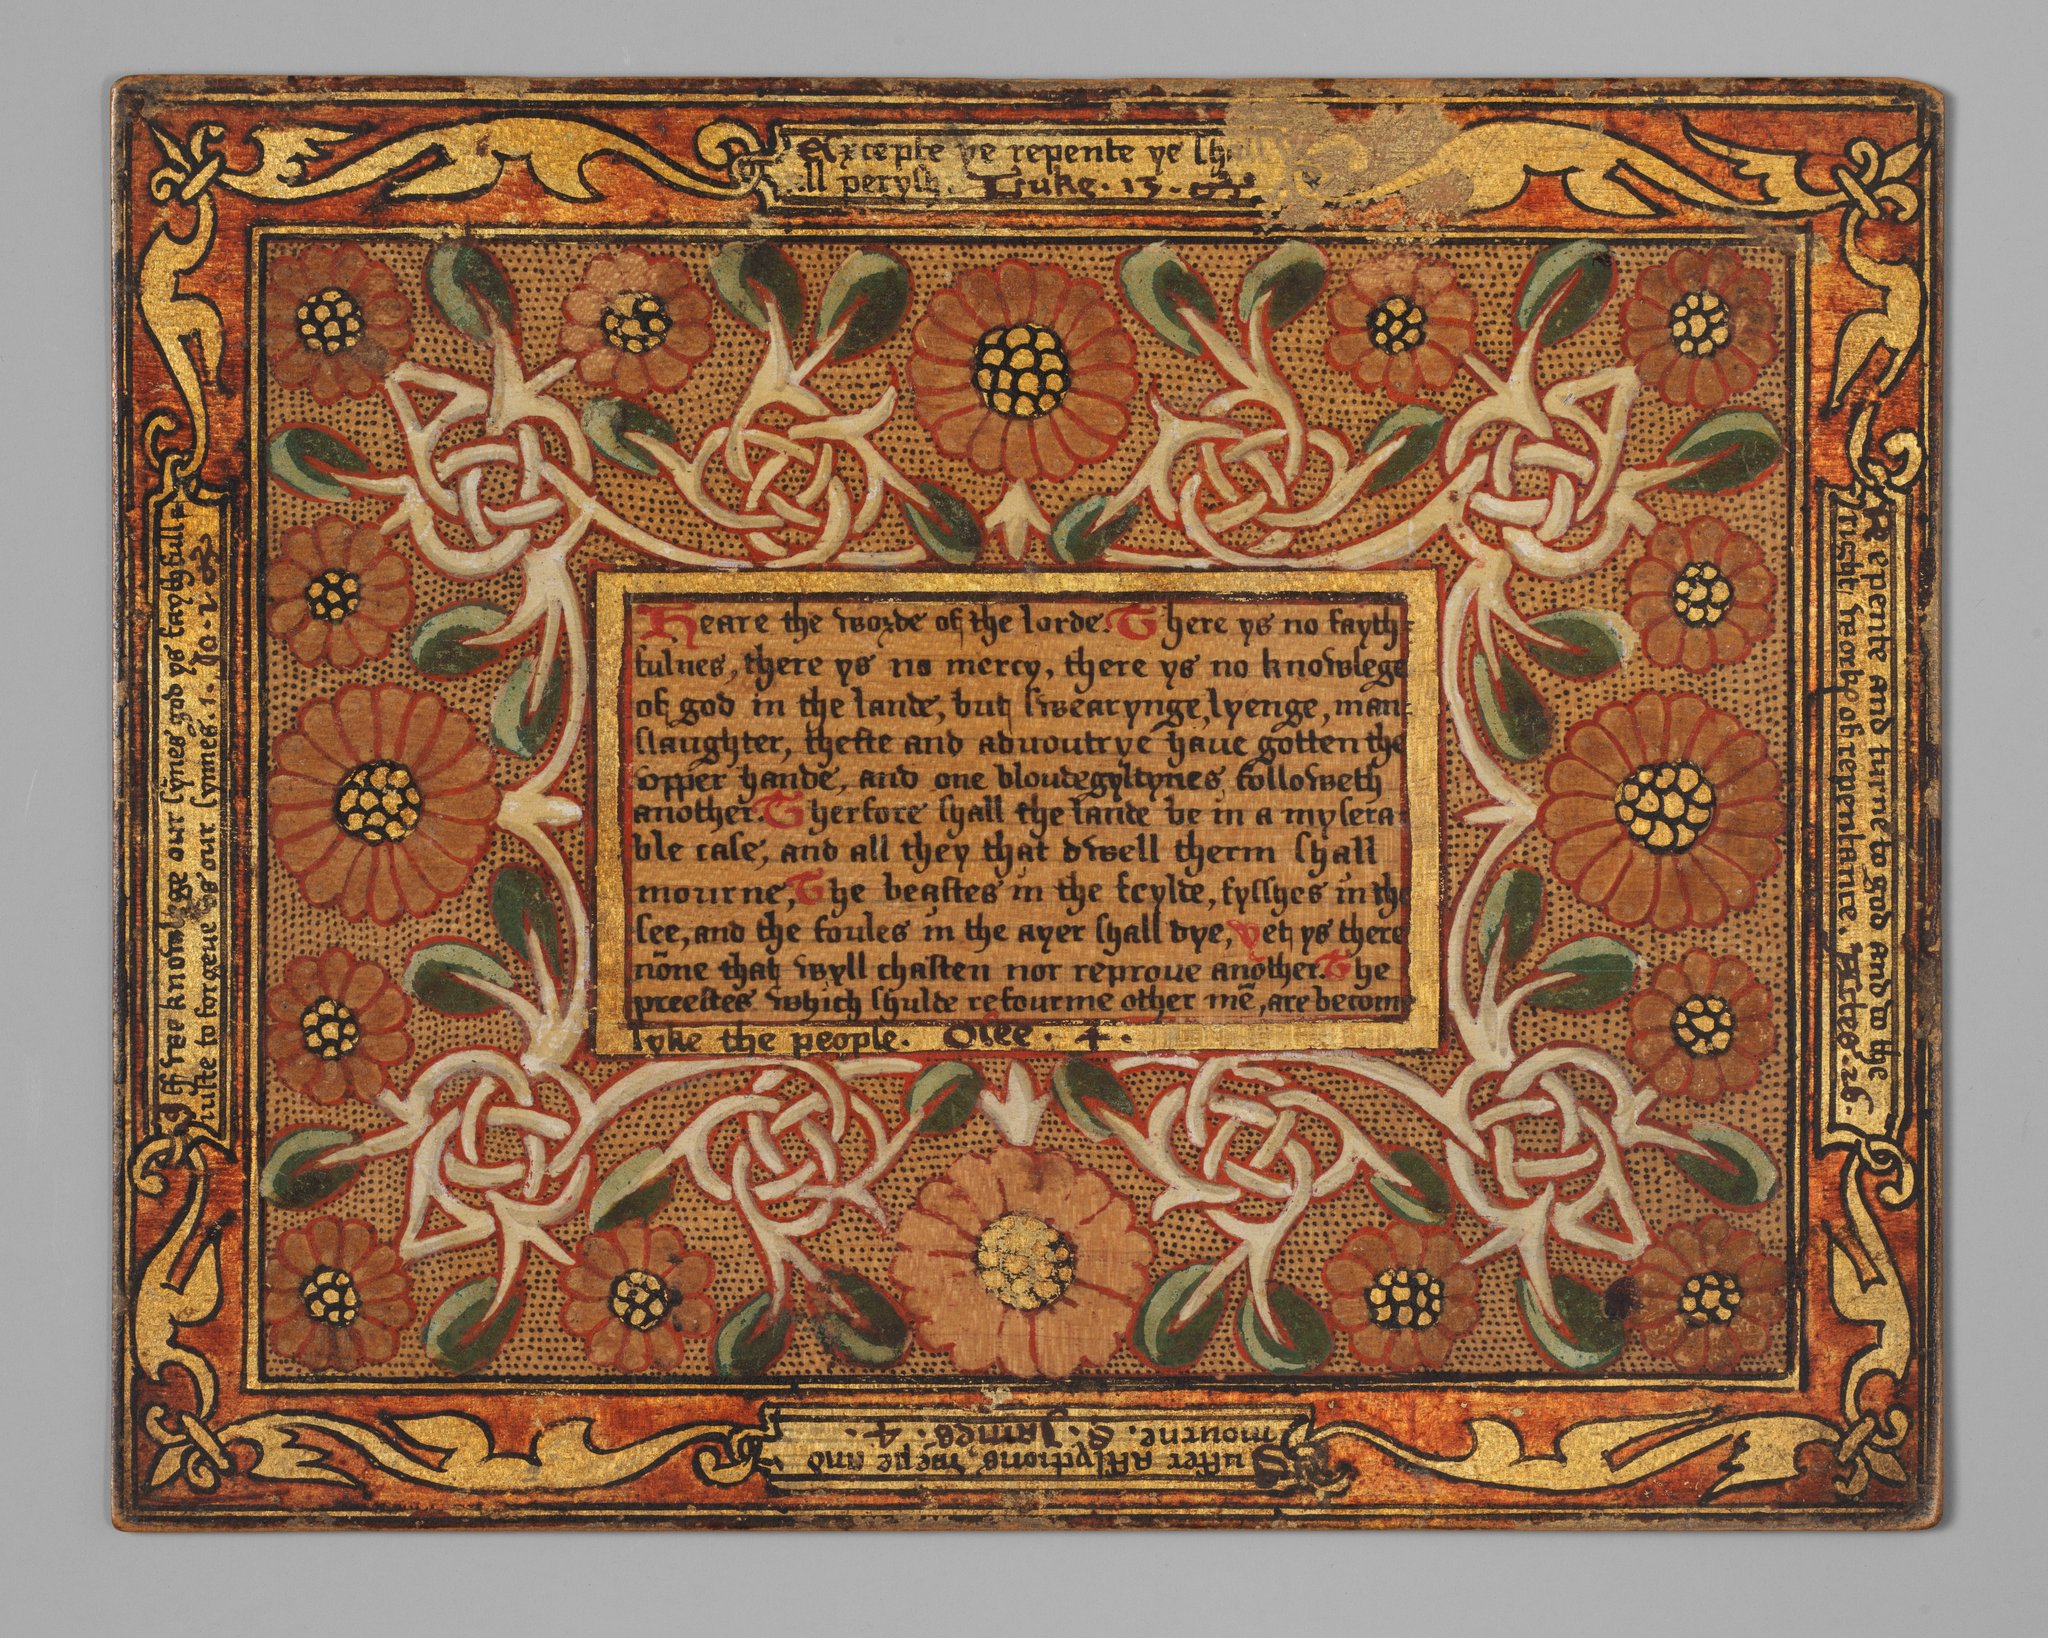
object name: trencher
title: Trencher with quotation from The Governance of Virtue (1566) (one of a set)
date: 1567-1600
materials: wood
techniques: gilding, painting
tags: flowers